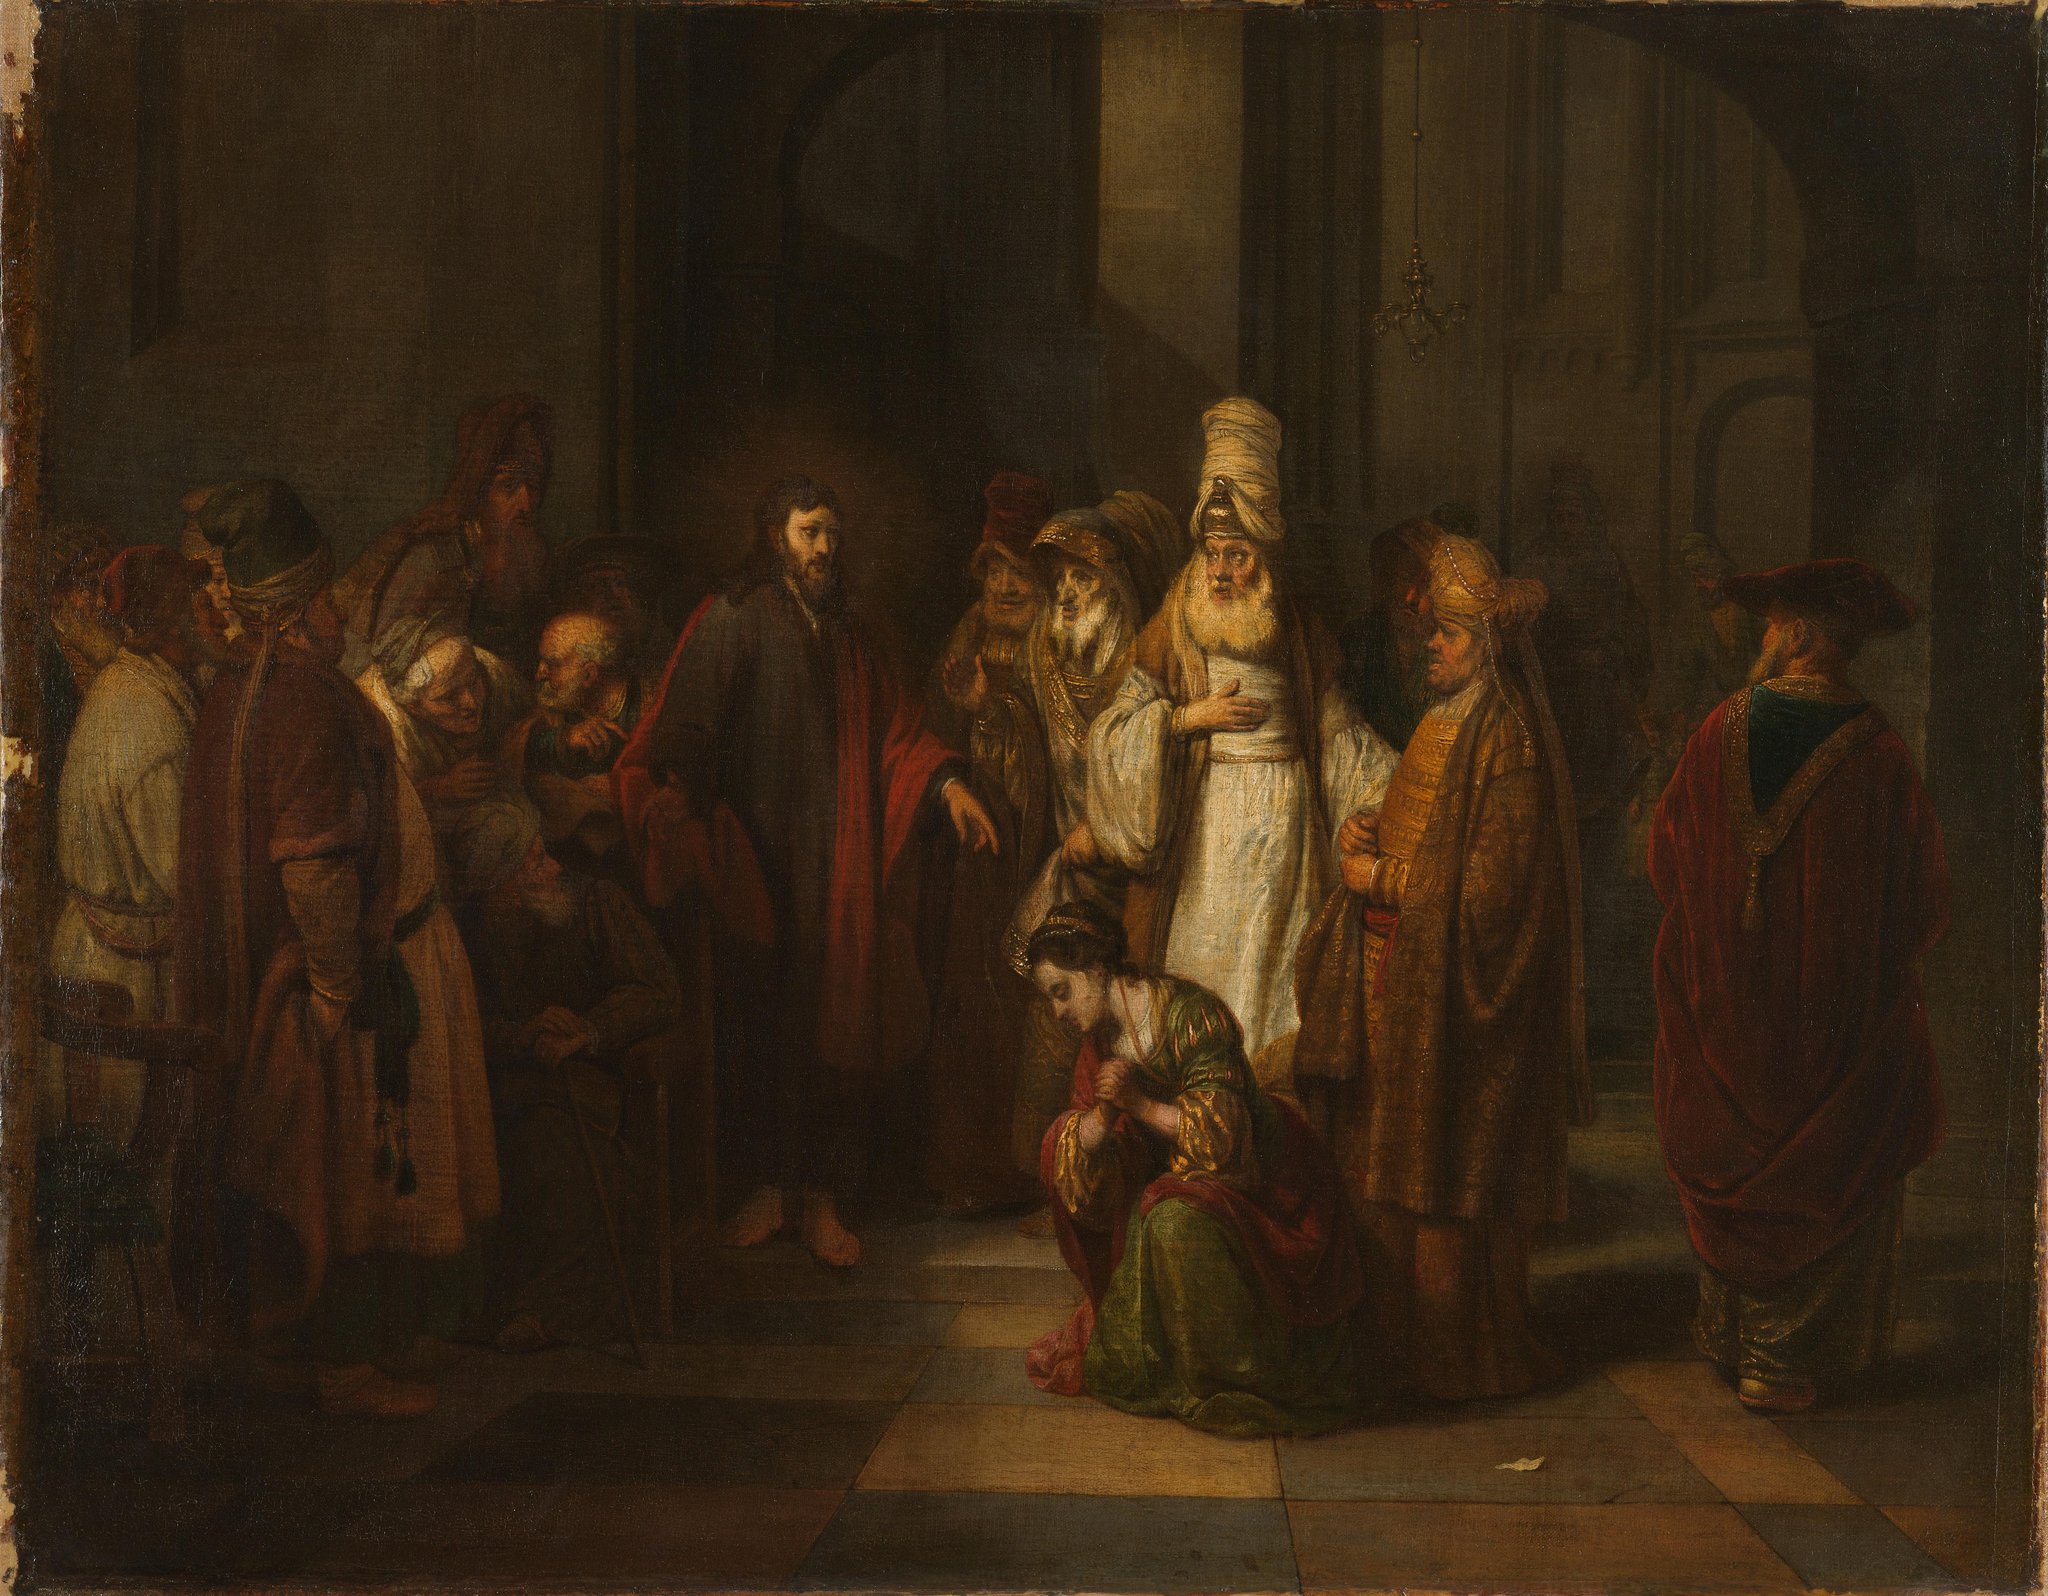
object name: painting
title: Christ and the Woman in Adultery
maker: gerbrand van den eeckhout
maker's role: draughtsman, print maker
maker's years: 1621-1674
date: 1650-1674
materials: canvas, oil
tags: pharisees bring a woman accused of adultery before christ (john 8:2-11)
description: Christus en de overspelige vrouw. Interieur of voorhof van een tempel waar Christus tussen priesters en Farizeeërs staat, voor hem knielt een jonge vrouw.